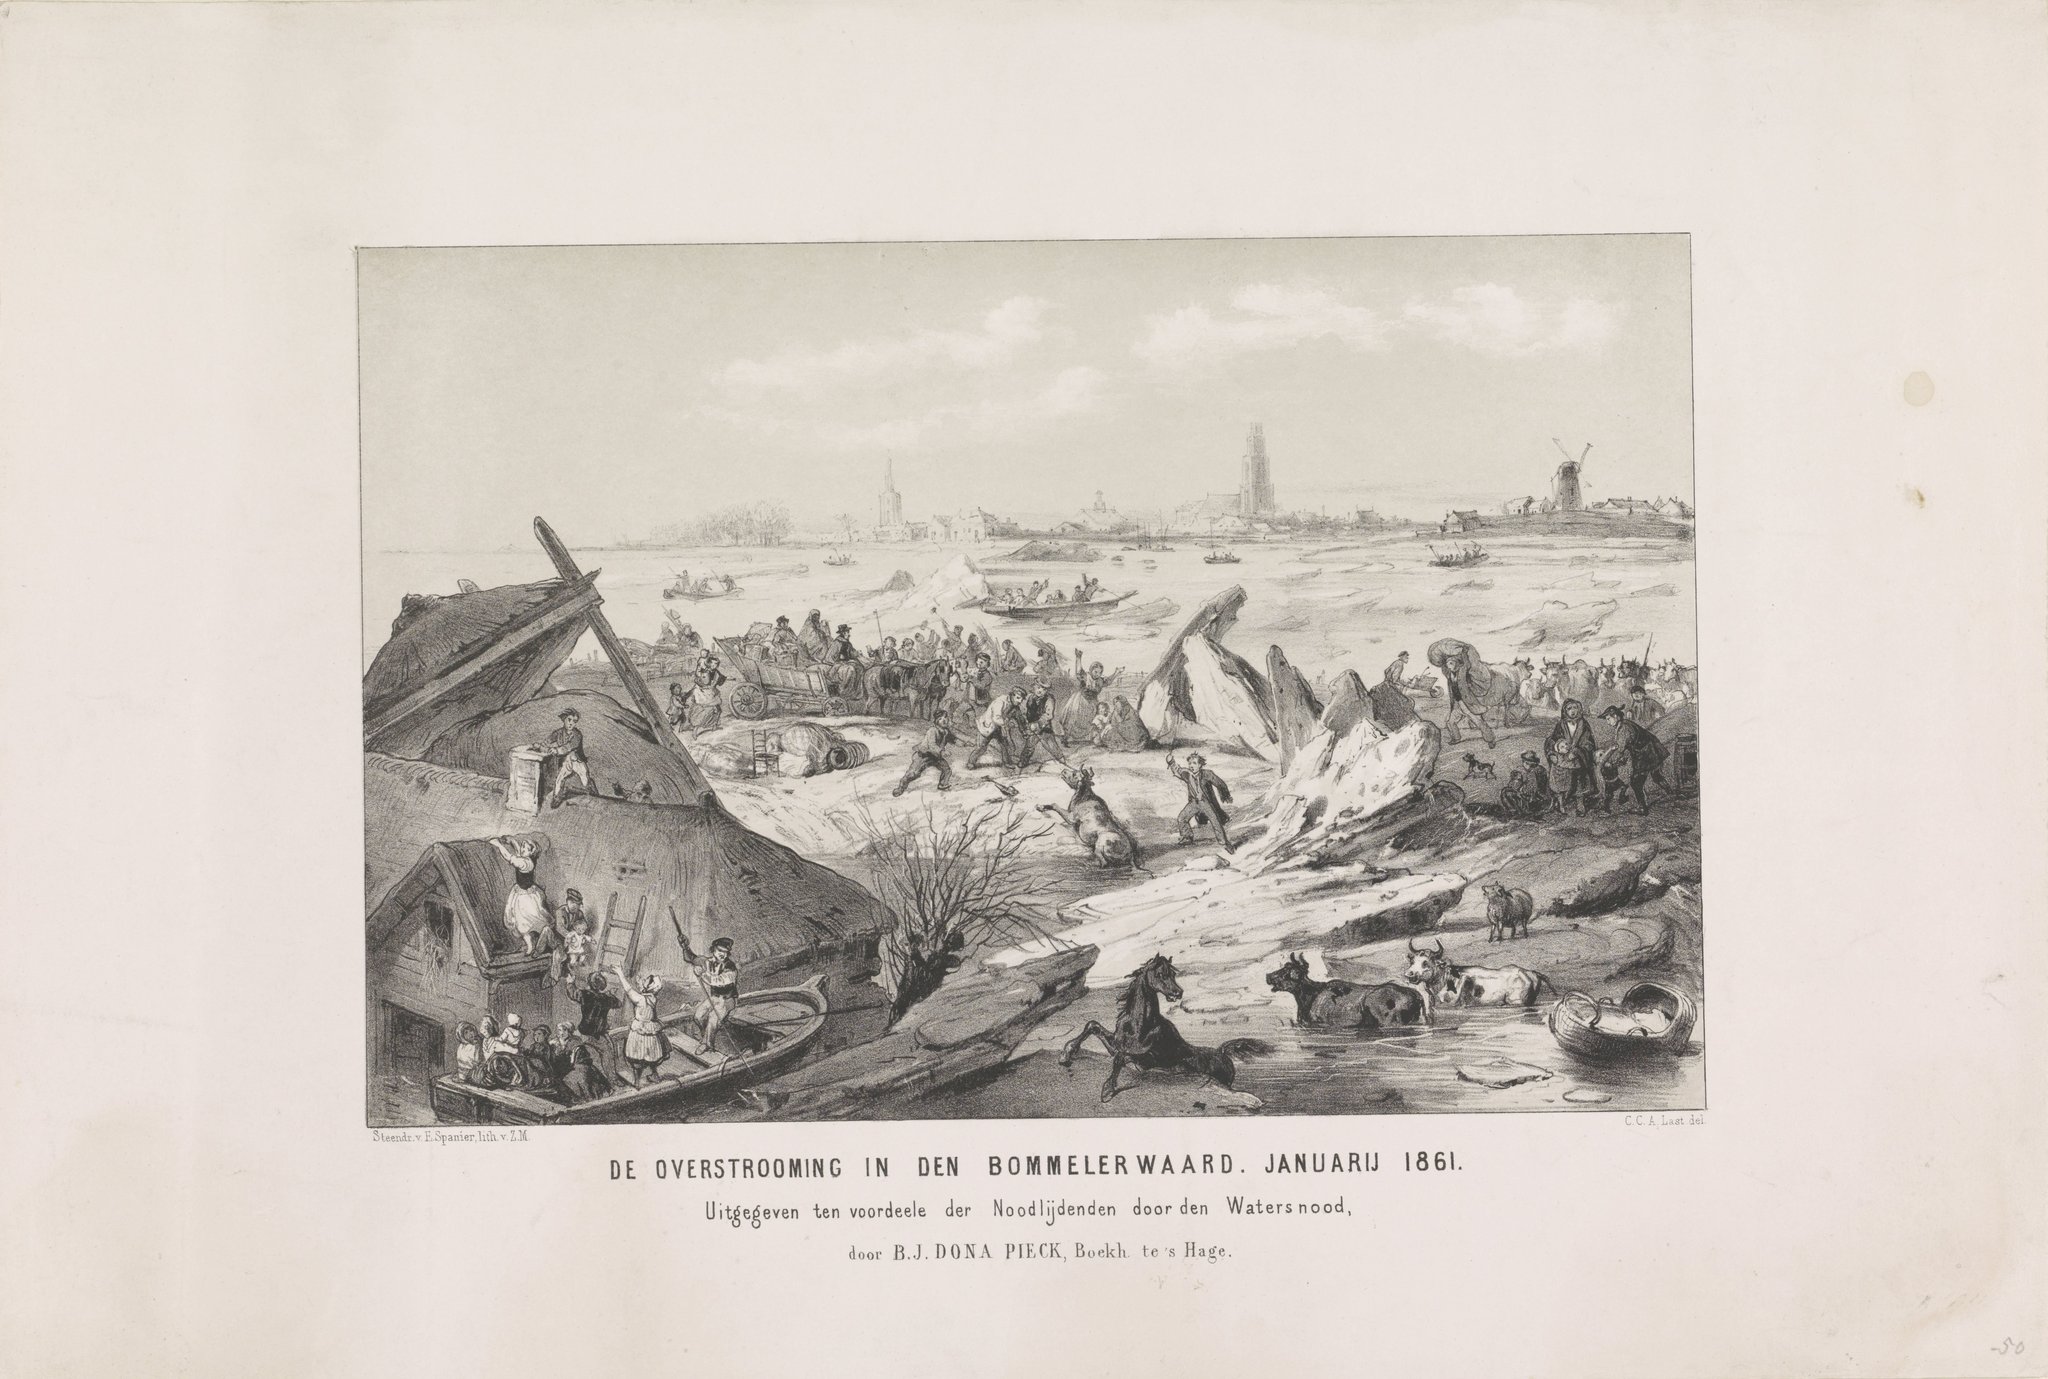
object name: print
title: De Overstrooming in den Bommelerwaard. Januarij 1861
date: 1861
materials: paper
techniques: lithograph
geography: the hague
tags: rescue work during a flood, flood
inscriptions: collector's mark: Lugt 2228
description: Watersnood in de Bommelerwaard, januari 1861. Links worden de bewoners van een boerderij met een bootje gered, over een dijk vluchten inwoners met vee en andere bezittingen langs de ijsschotten.